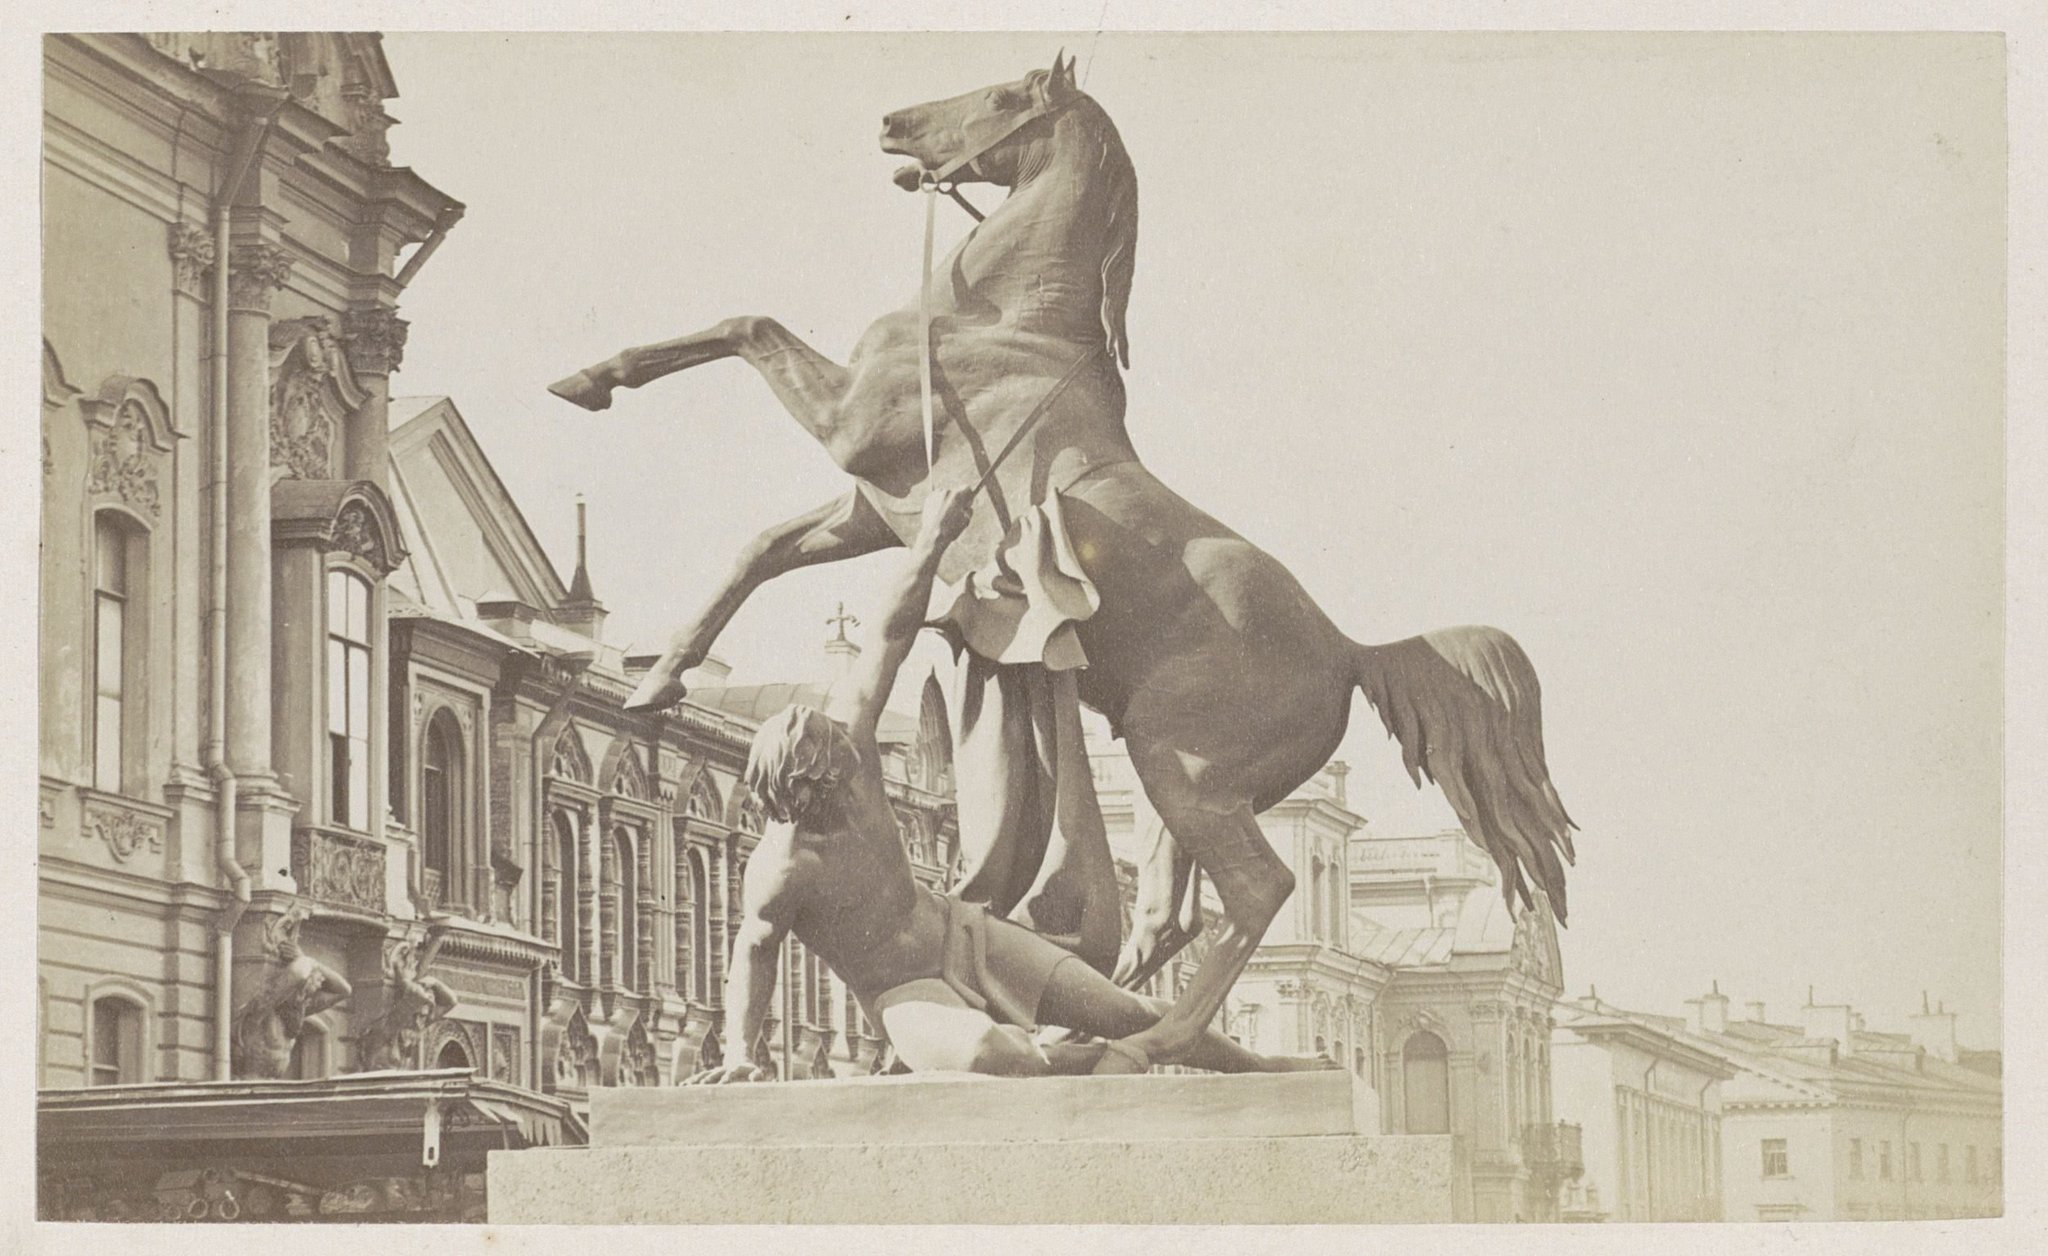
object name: photograph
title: Beeld van een paardentemmer op de Anichkovbrug in Sint Petersburg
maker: Anonymous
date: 1878-1890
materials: photographic support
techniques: albumen print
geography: sint-petersburg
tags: equestrian statue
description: Onderdeel van Reisalbum Europese steden, vermoedelijk Zweeds.